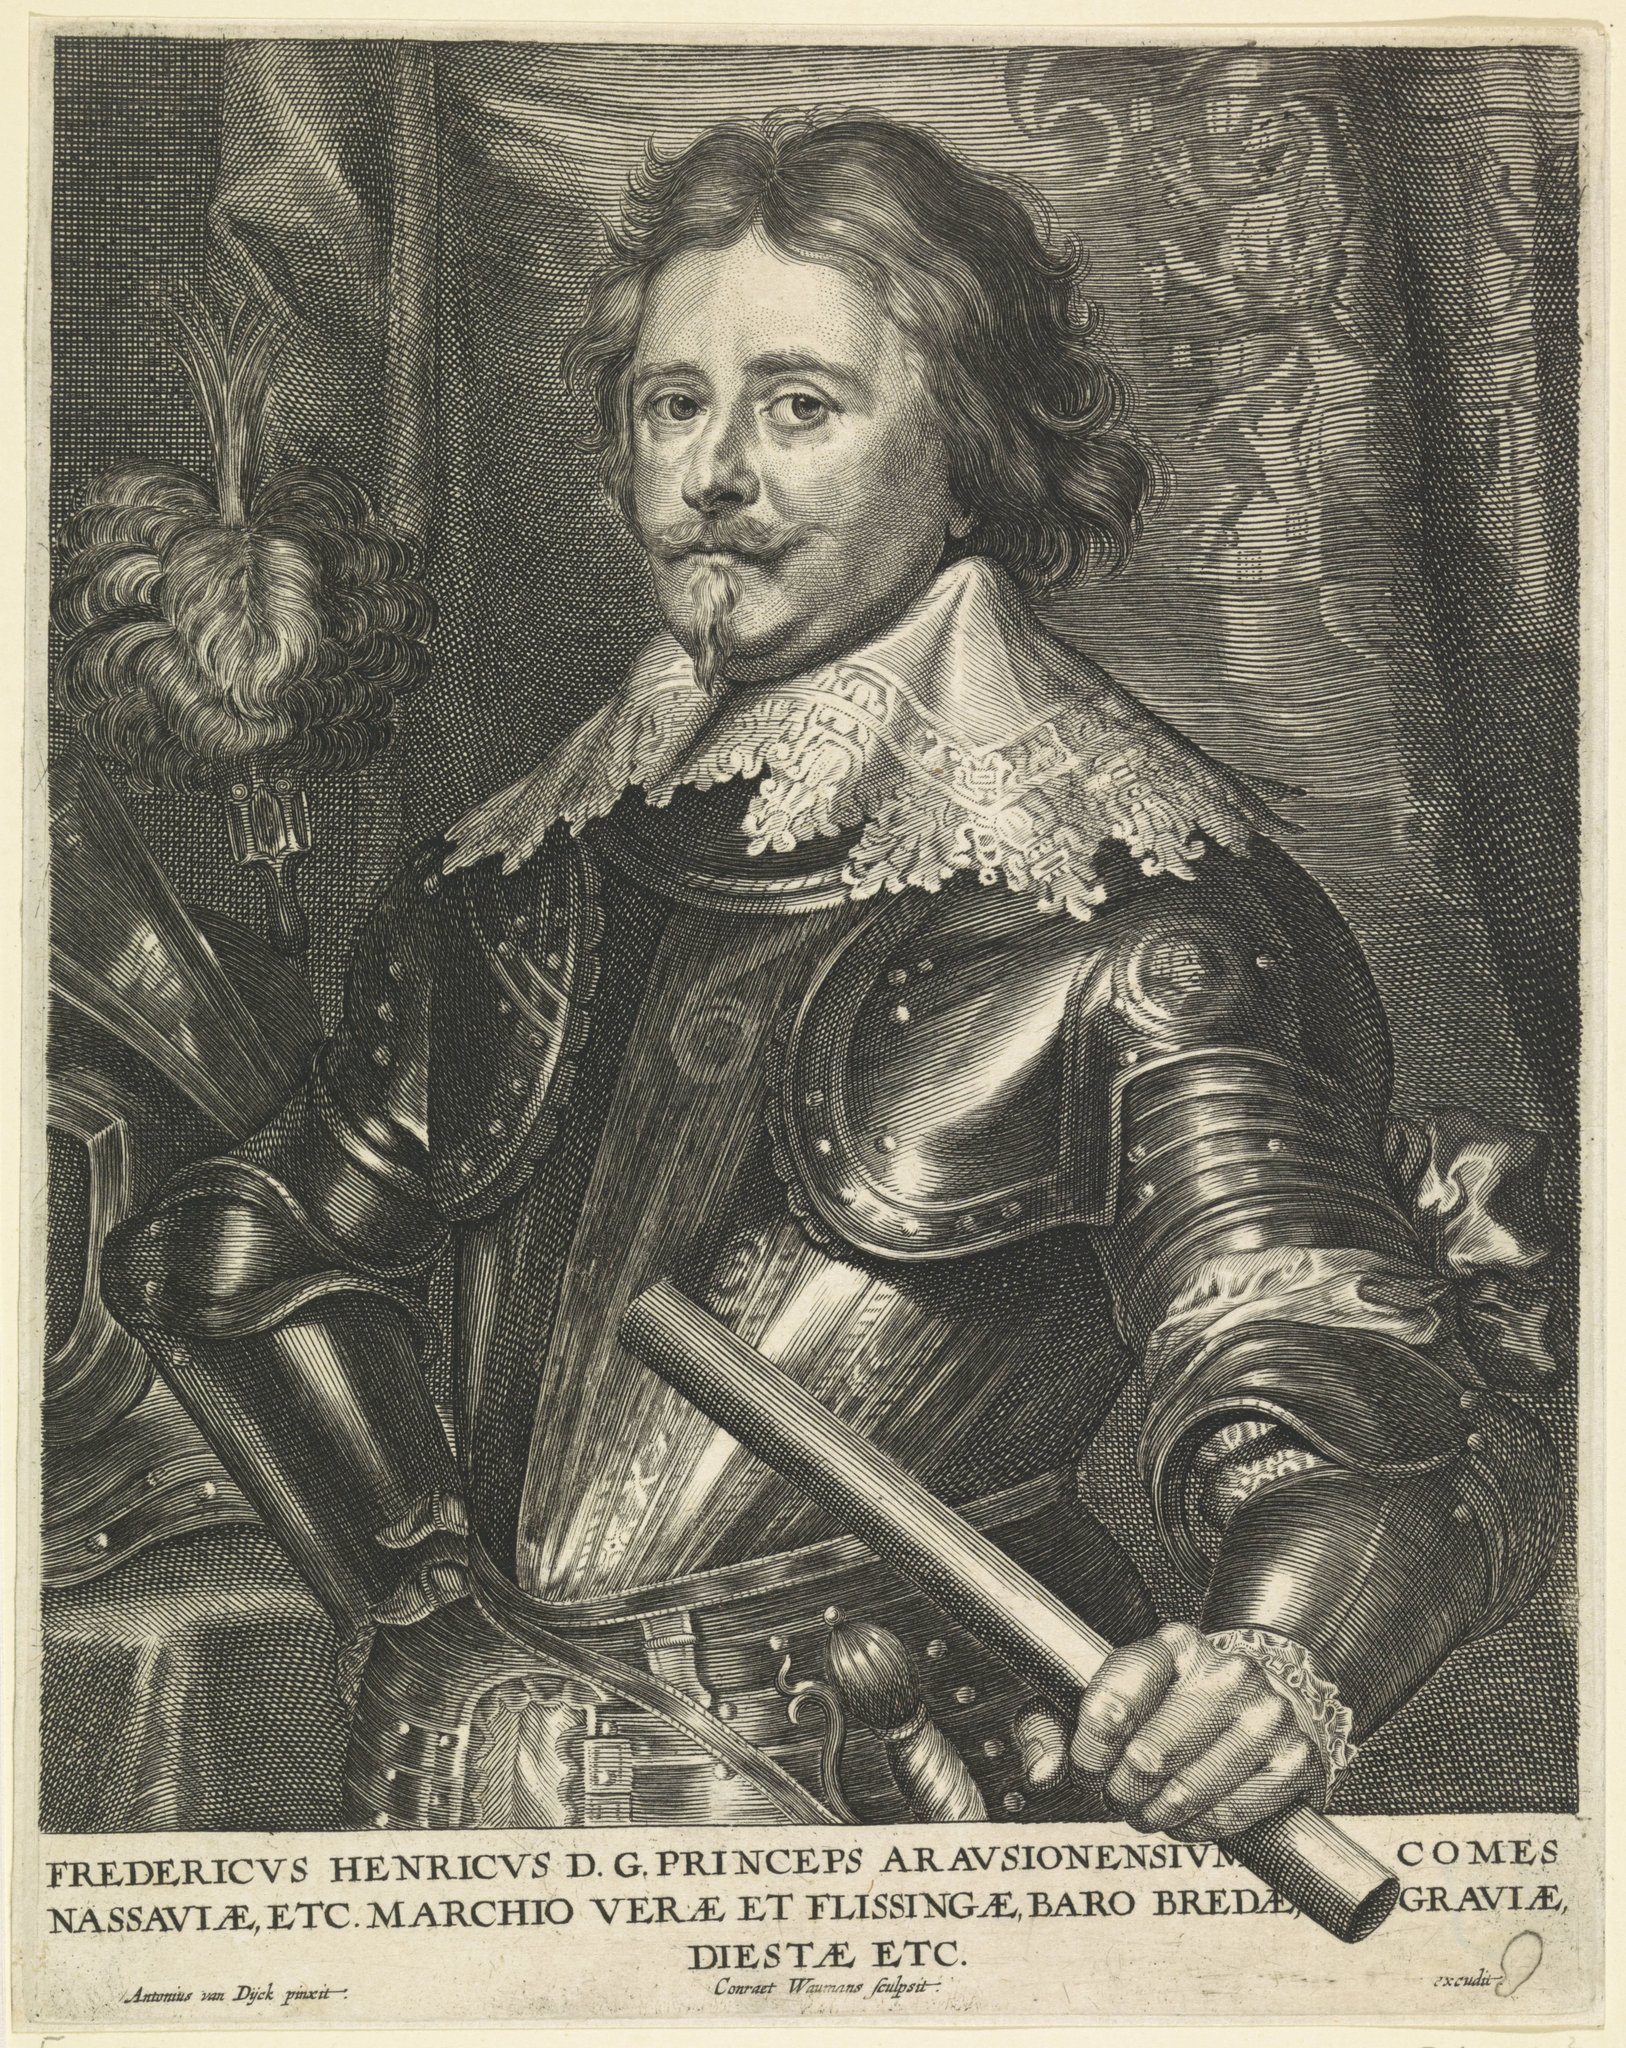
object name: print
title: Portret van Frederik Hendrik, prins van Oranje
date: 1640-1641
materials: paper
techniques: engraving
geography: southern netherlands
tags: the hague, frederick henry (prince of orange)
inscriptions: collector's mark: Lugt 963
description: De hier vermelde titel verwijst naar de hoogst verkregen titel van de geportretteerde, niet per se naar de titel die de geportretteerde op deze voorstelling draagt.